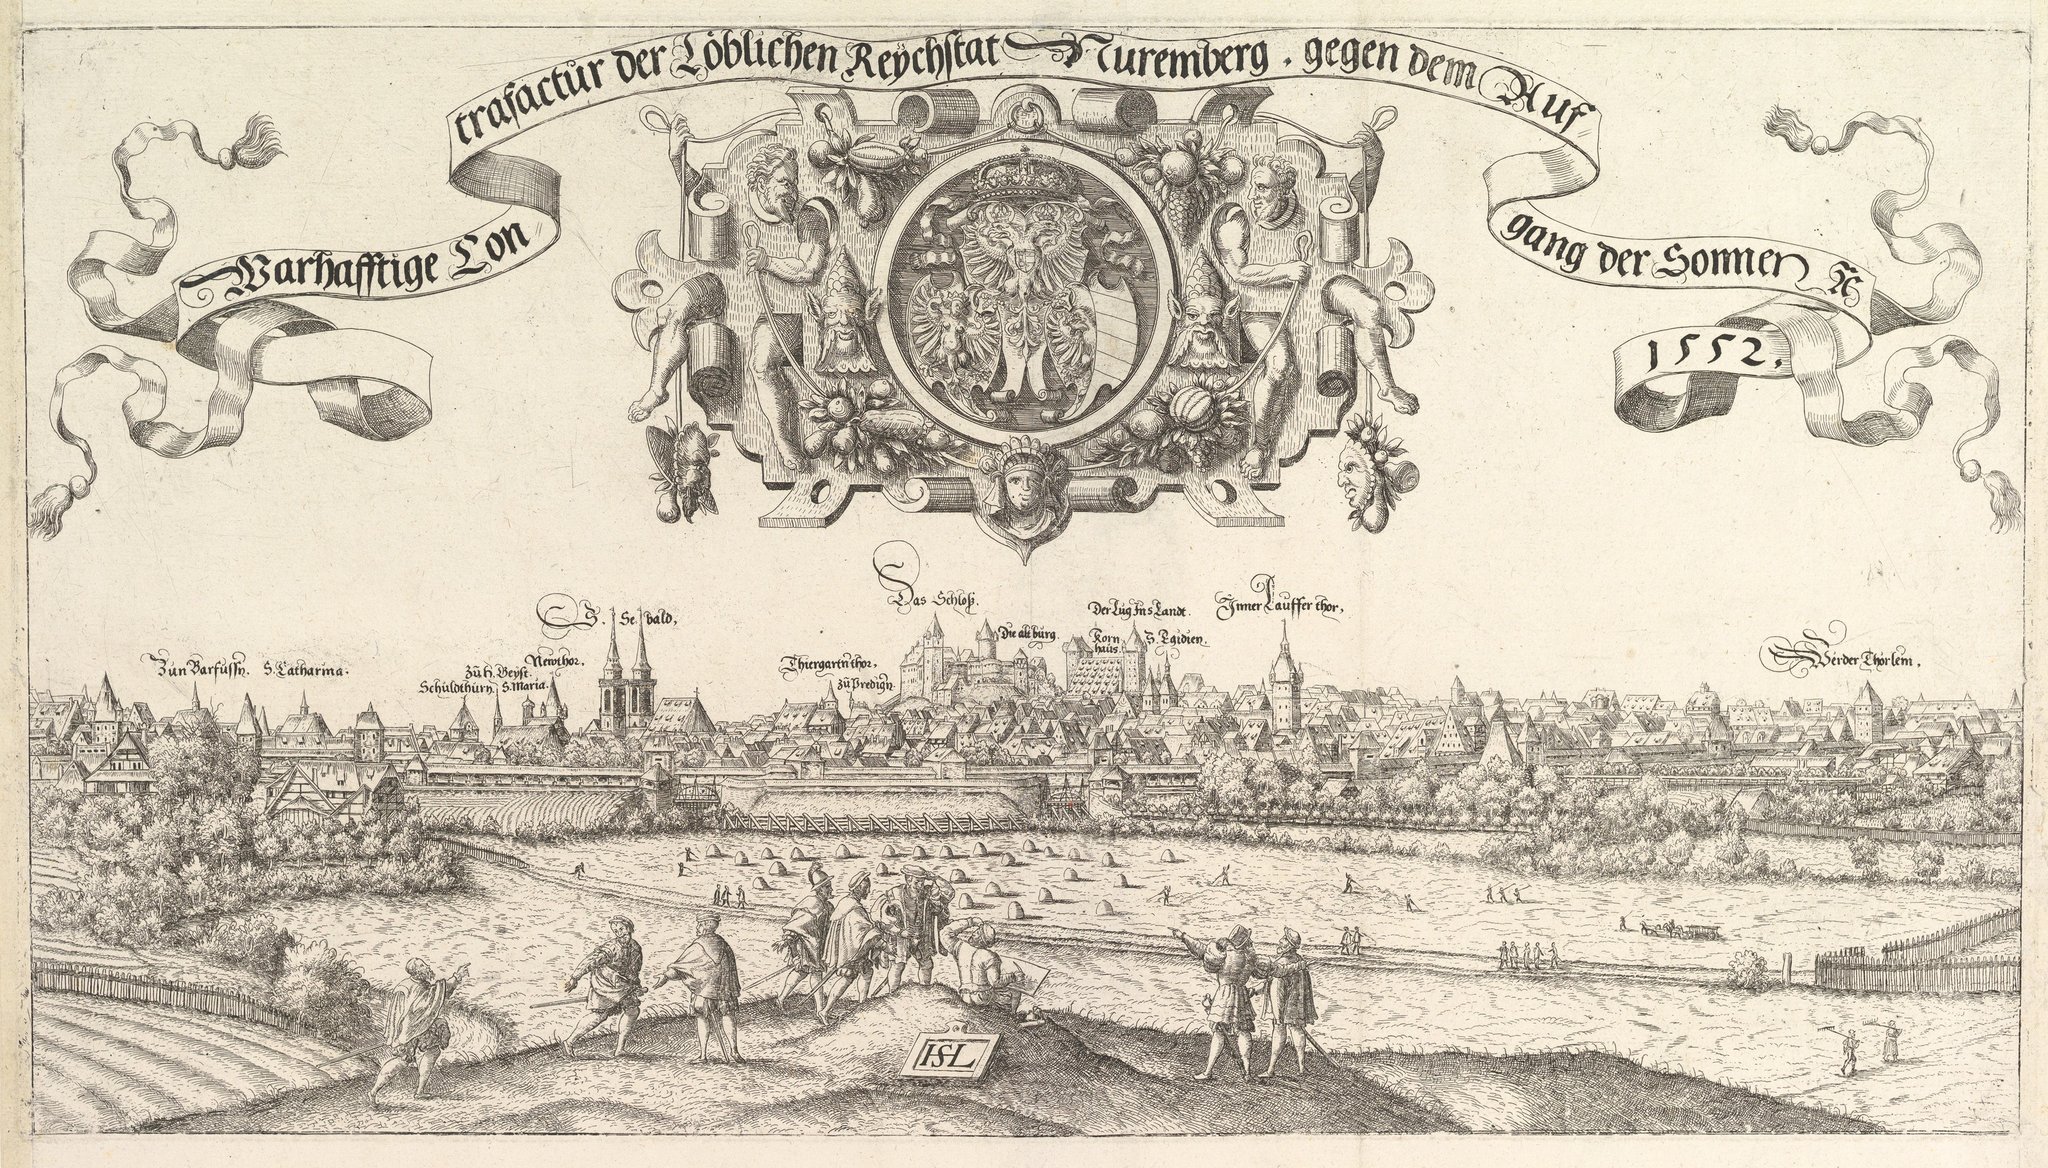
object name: print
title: View of Nuremberg, to the east, center plate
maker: hanns lautensack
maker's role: artist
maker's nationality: german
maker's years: 1515-1566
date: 1552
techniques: etching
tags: human figures